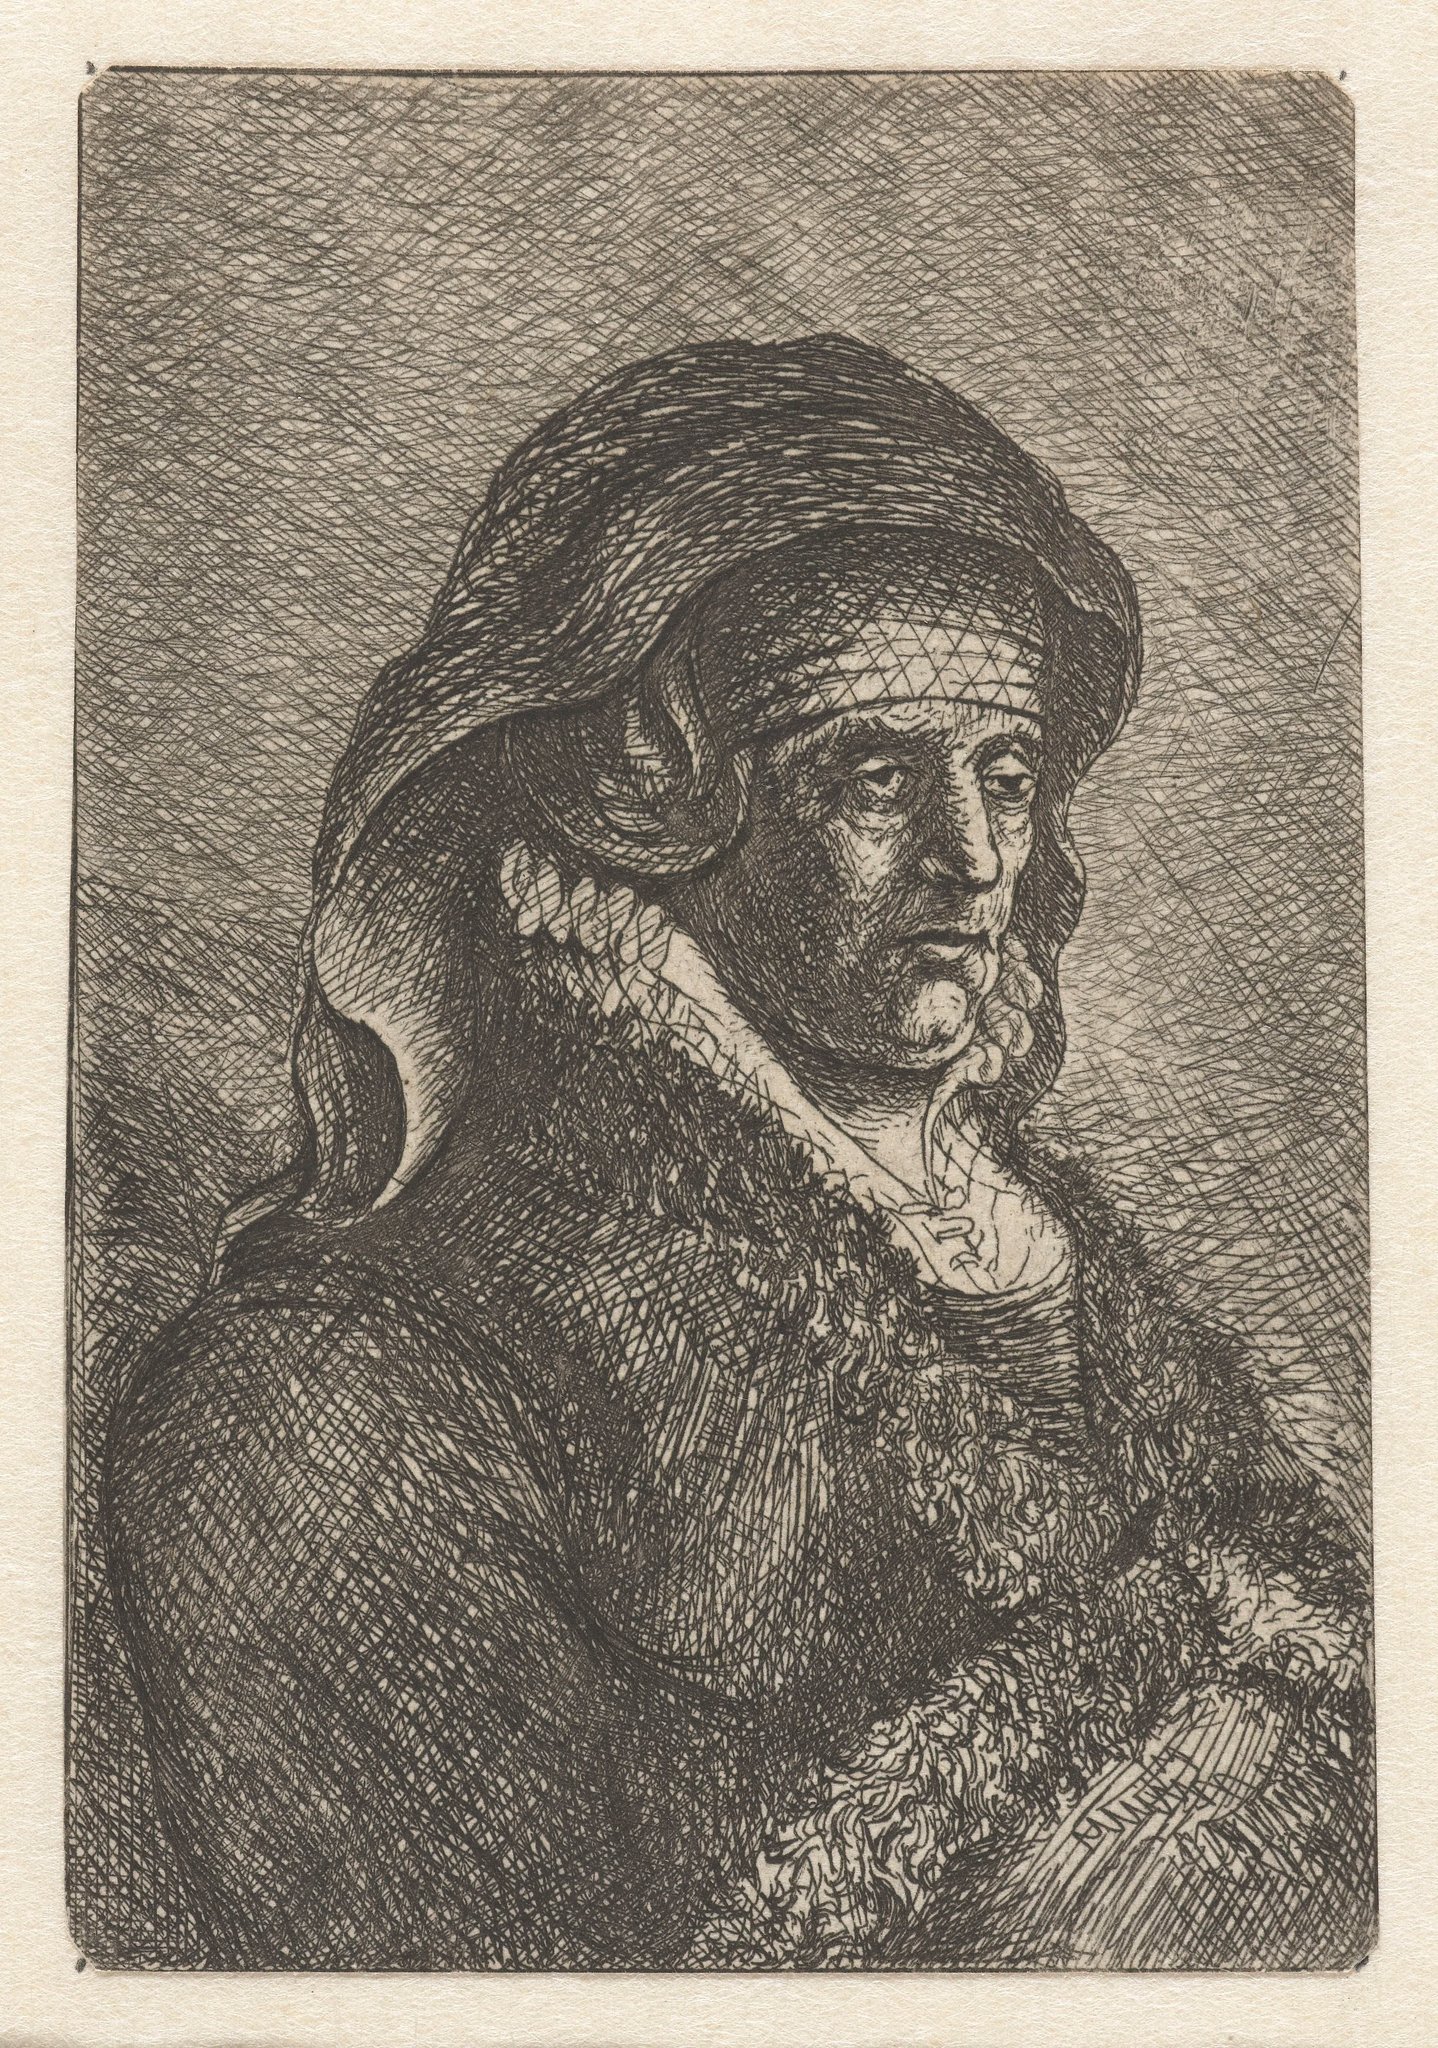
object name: print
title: The artist's mother seated at a table, looking right: three quarter length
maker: Anonymous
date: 1631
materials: paper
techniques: etching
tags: historical persons - bb - woman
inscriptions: collector's mark: Lugt 2760, collector's mark: Lugt 2228